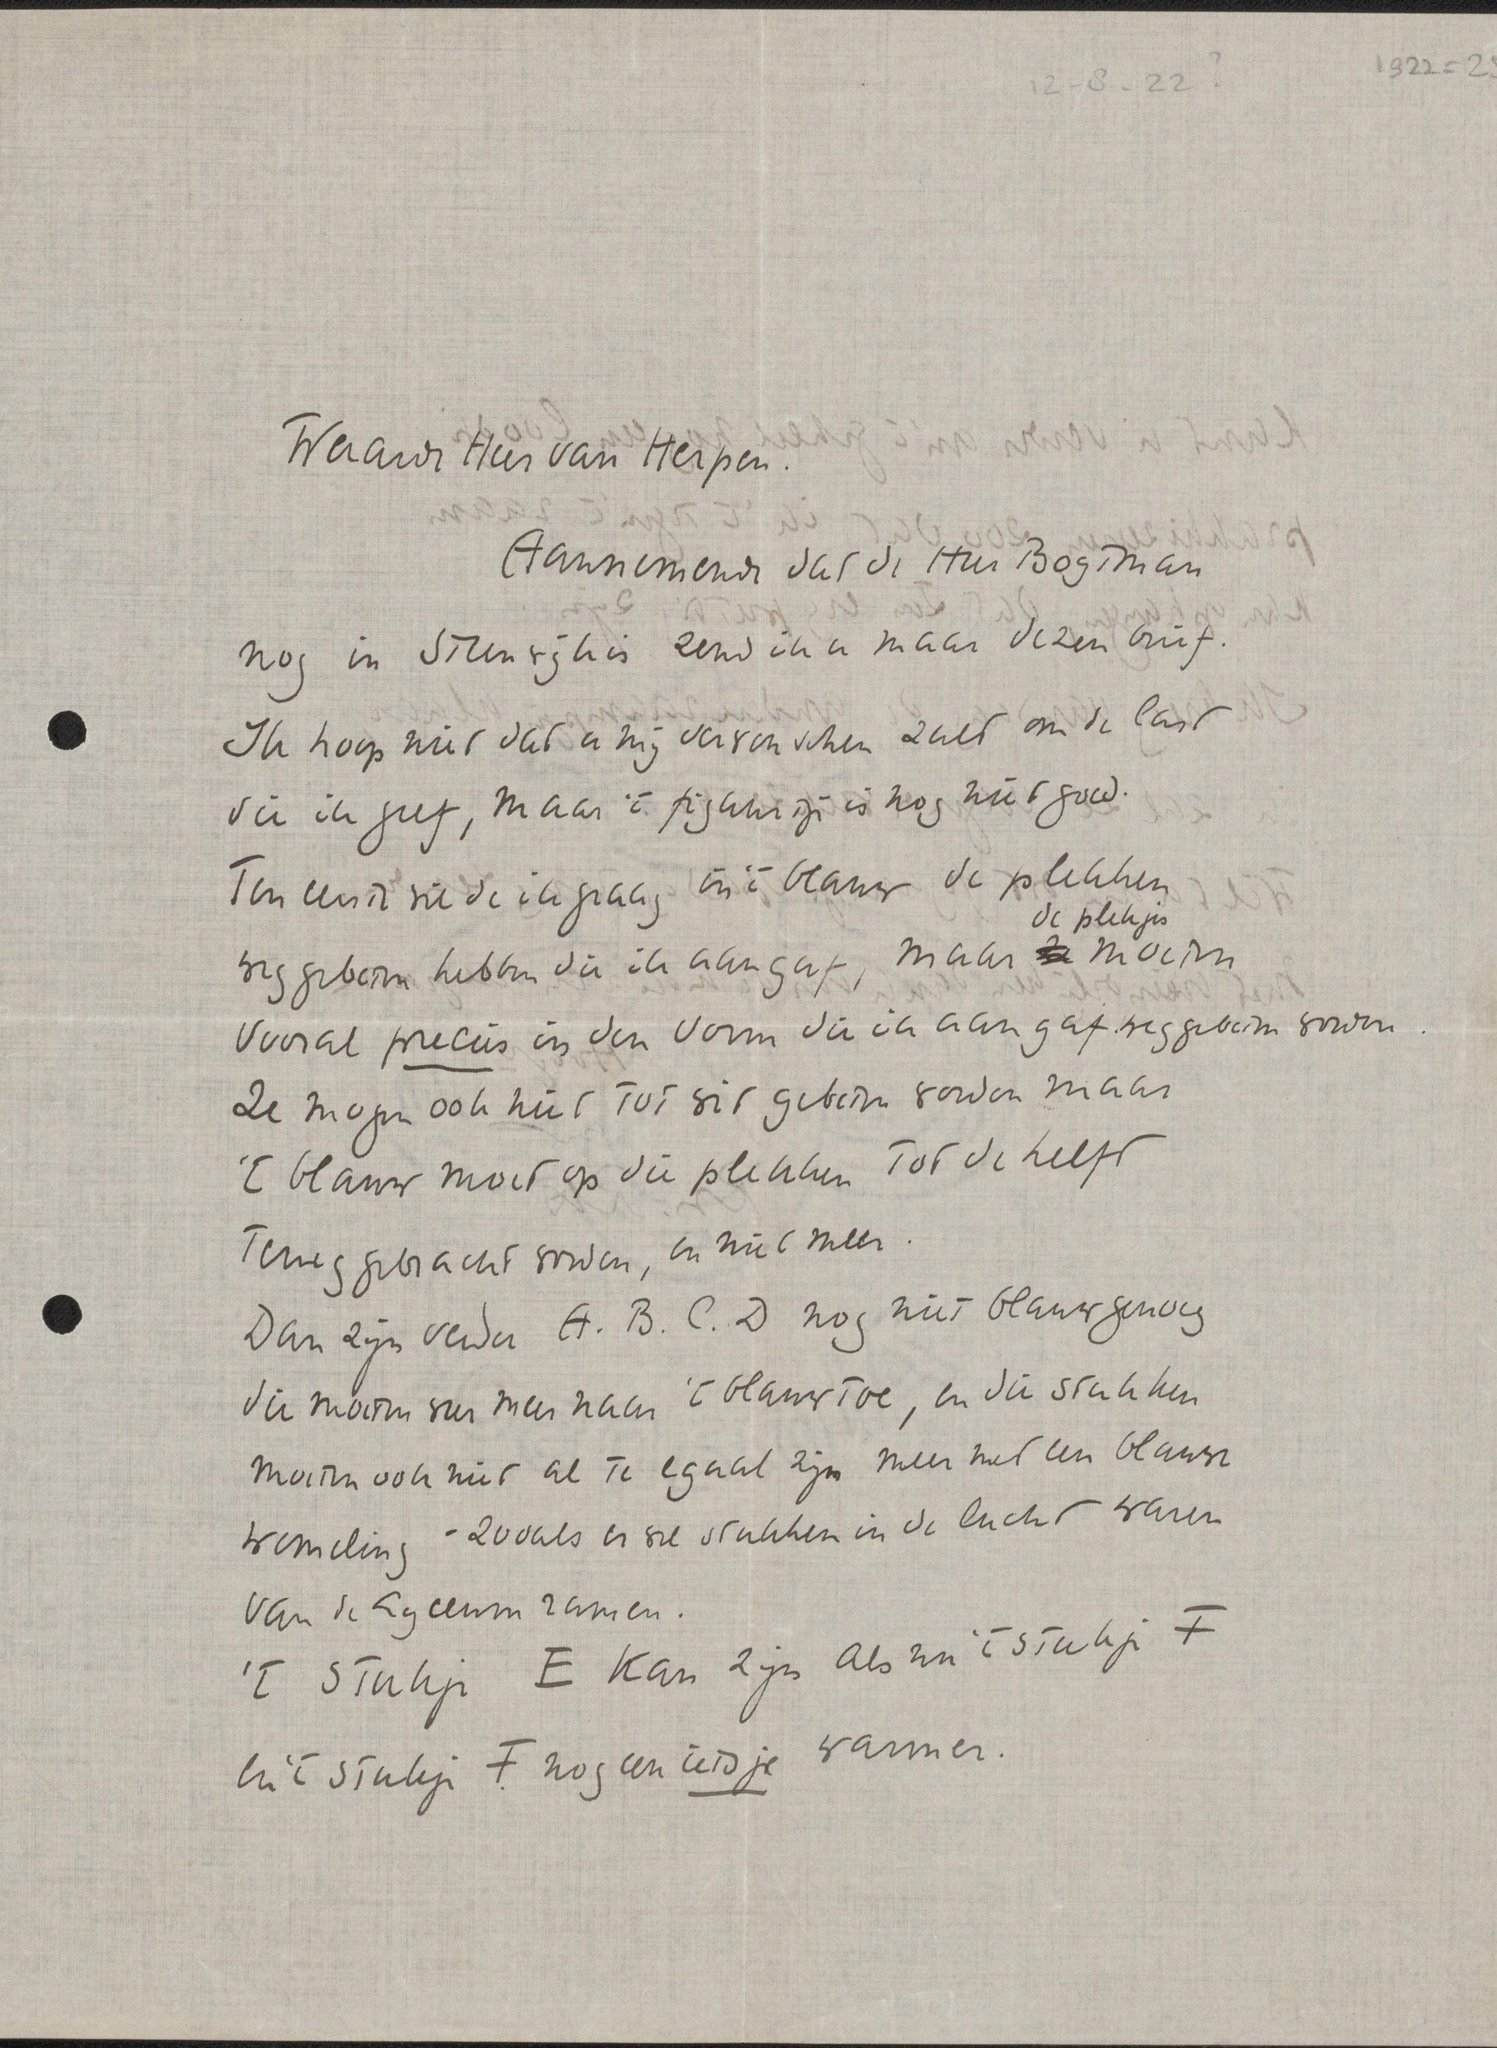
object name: letter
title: Brief aan de heer van Herpen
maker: richard nicolaüs roland holst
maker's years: 1868-1938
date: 1922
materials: ink, paper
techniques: pen, writing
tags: willem bogtman, applied arts, arts and crafts; industrial design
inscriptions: watermark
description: Brief gedateerd 12 augustus 1922 in latere hand.